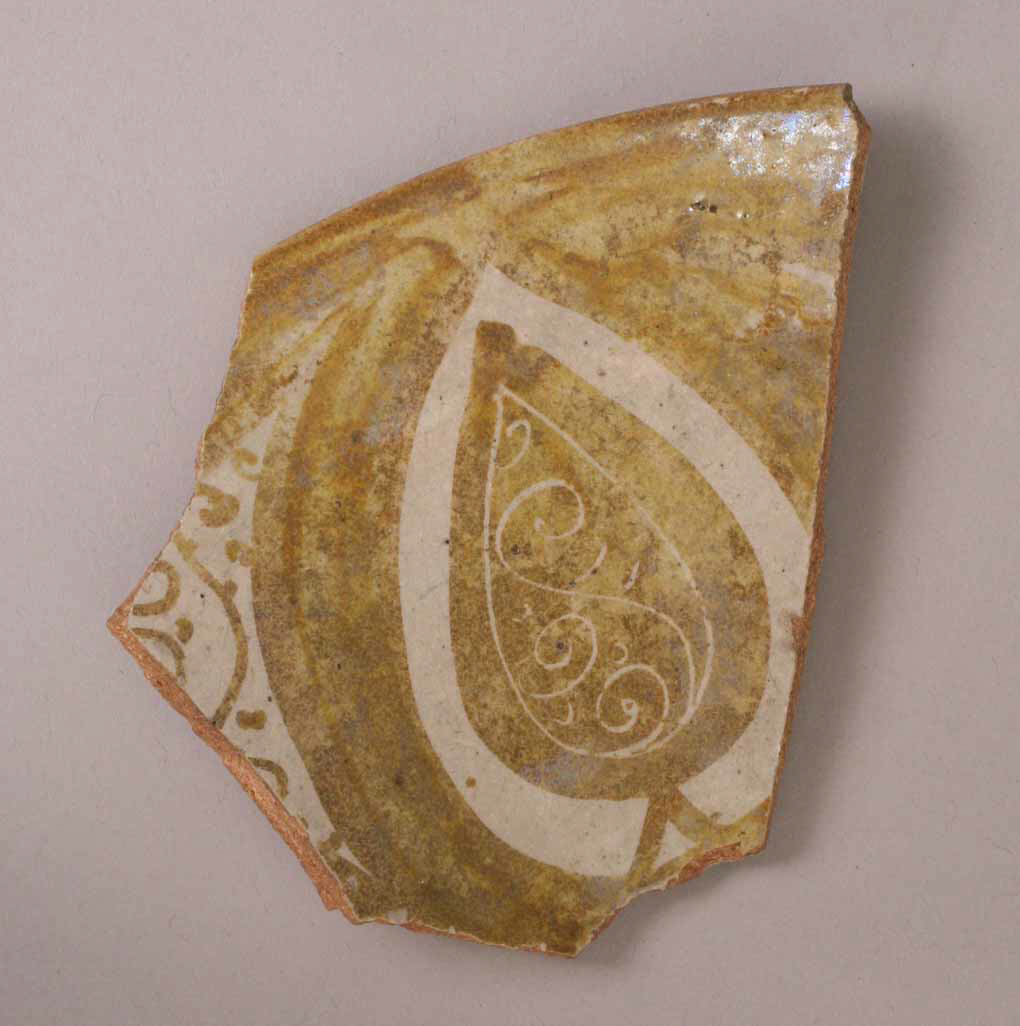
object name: ceramic fragment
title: Fragment of a Dish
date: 1001-1200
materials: earthenware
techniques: luster painting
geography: egypt